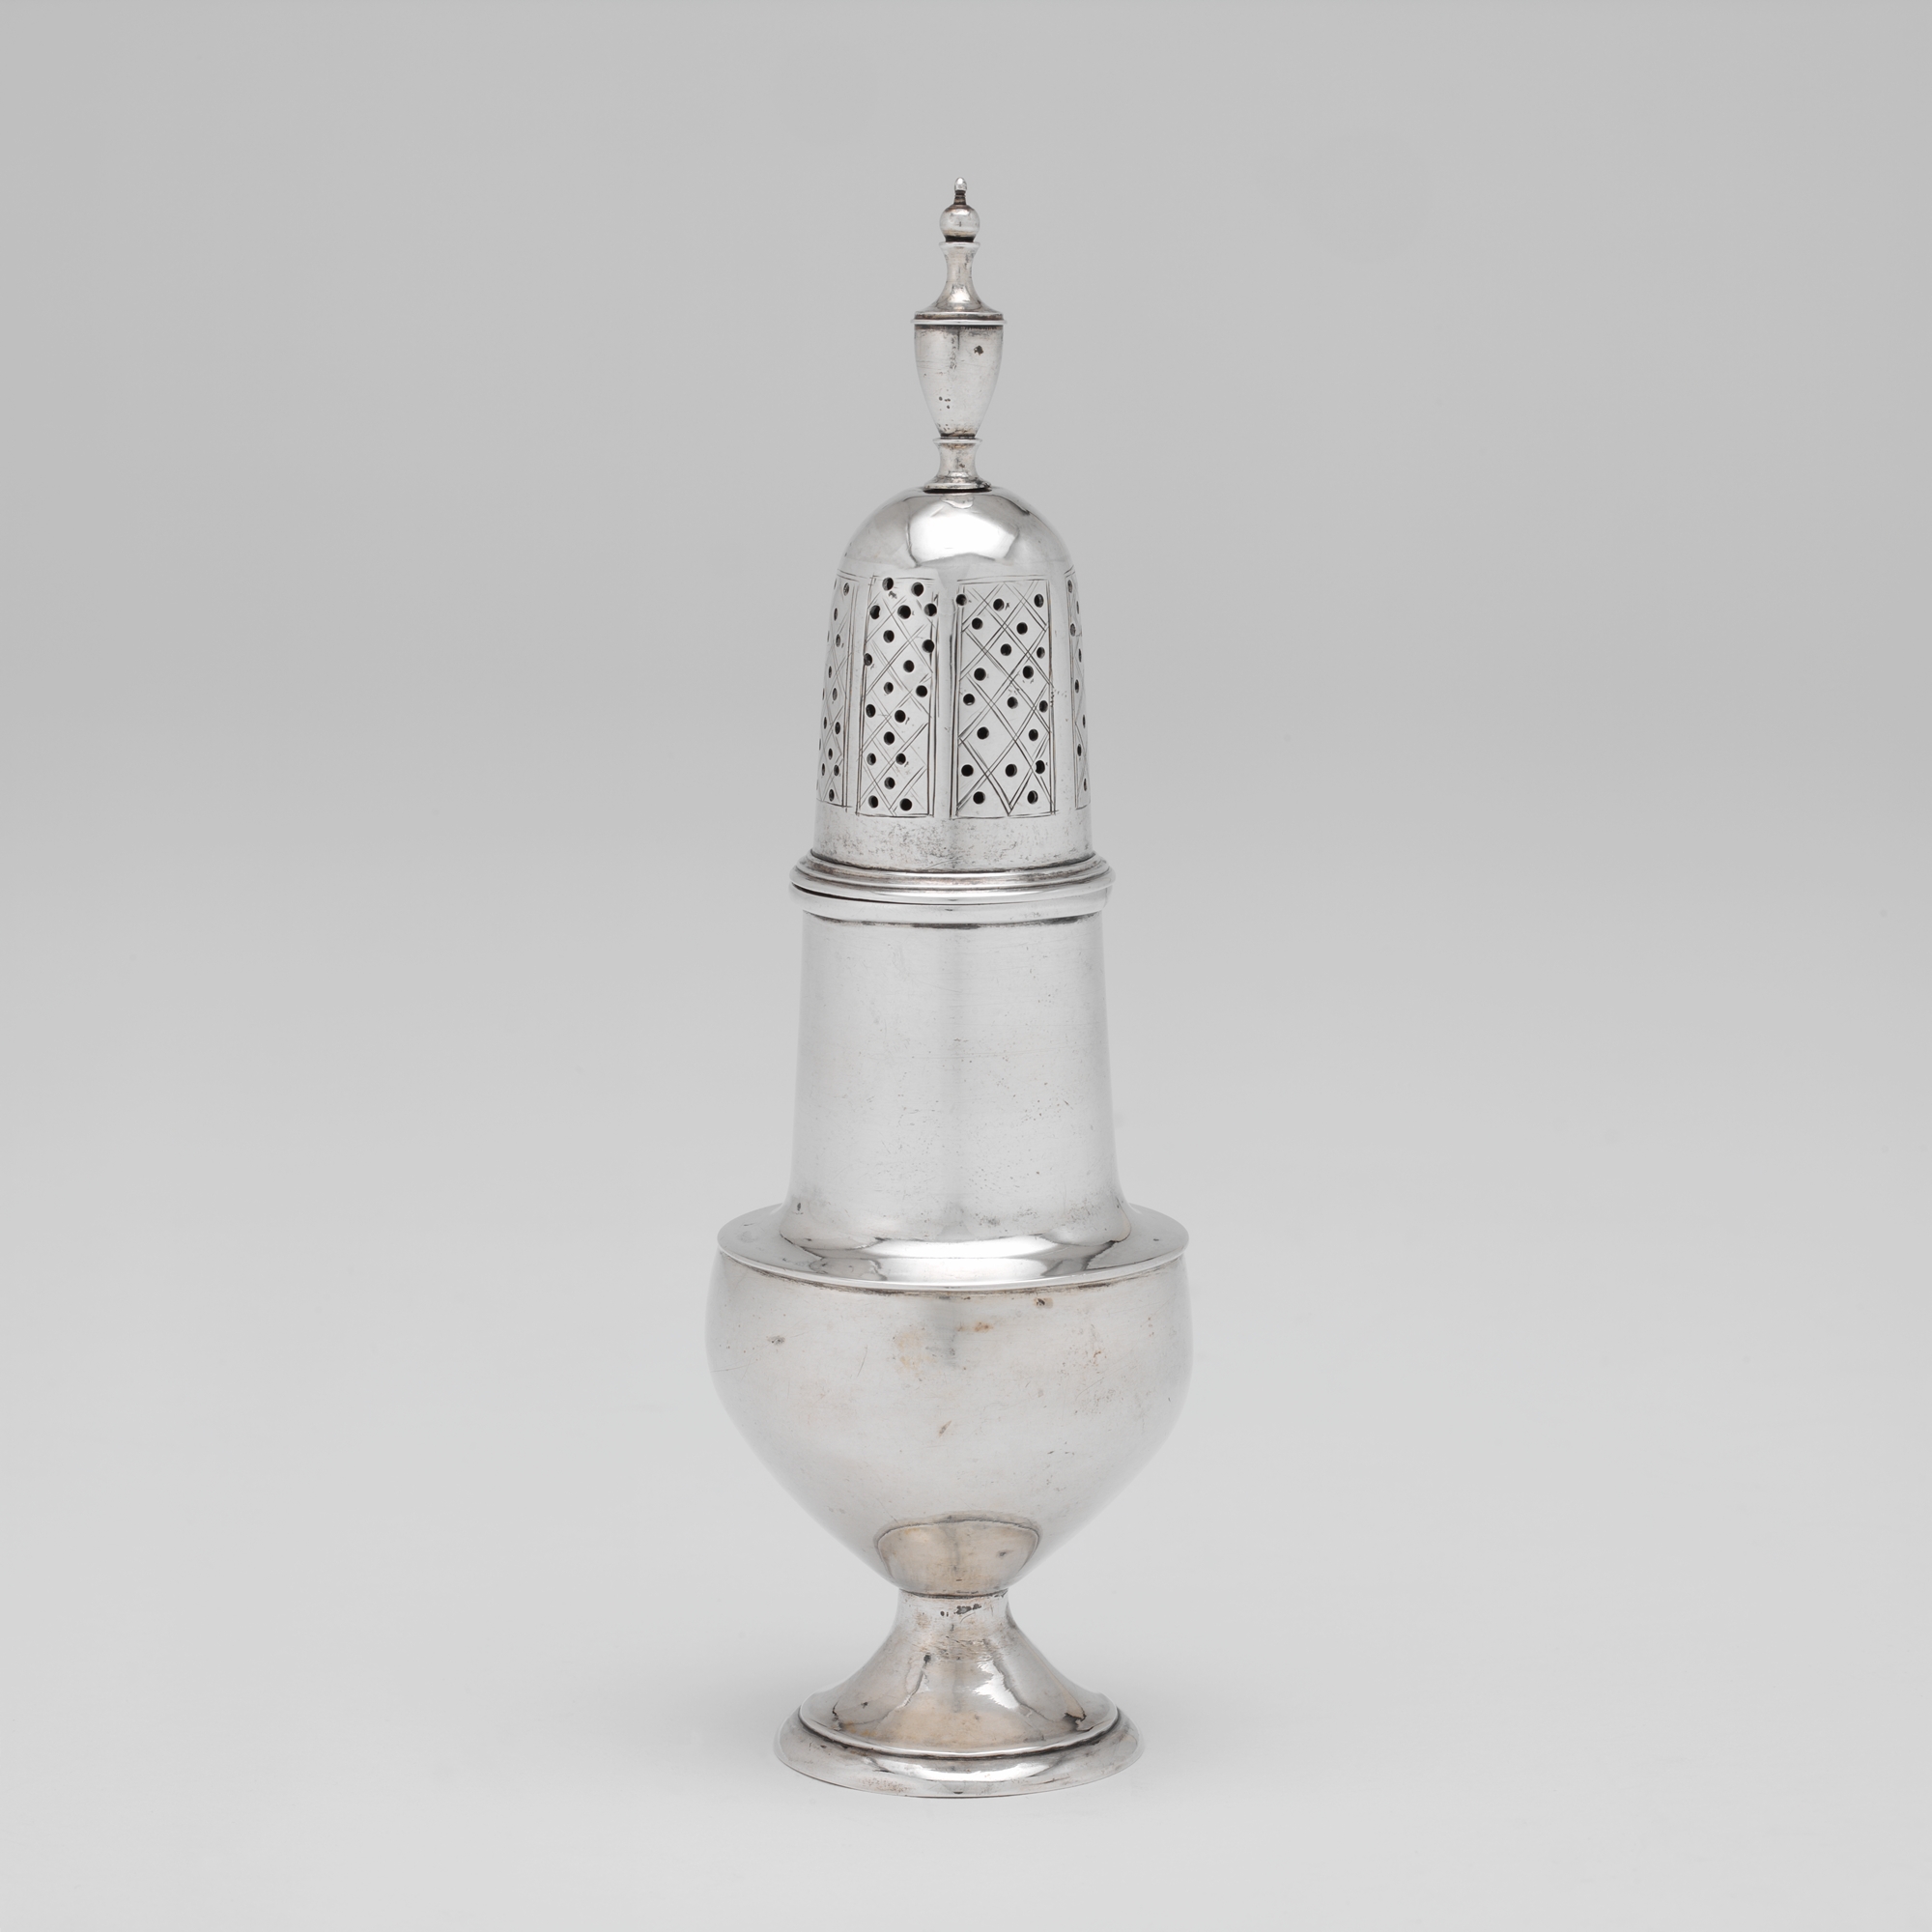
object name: caster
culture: american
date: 1770-1800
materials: silver